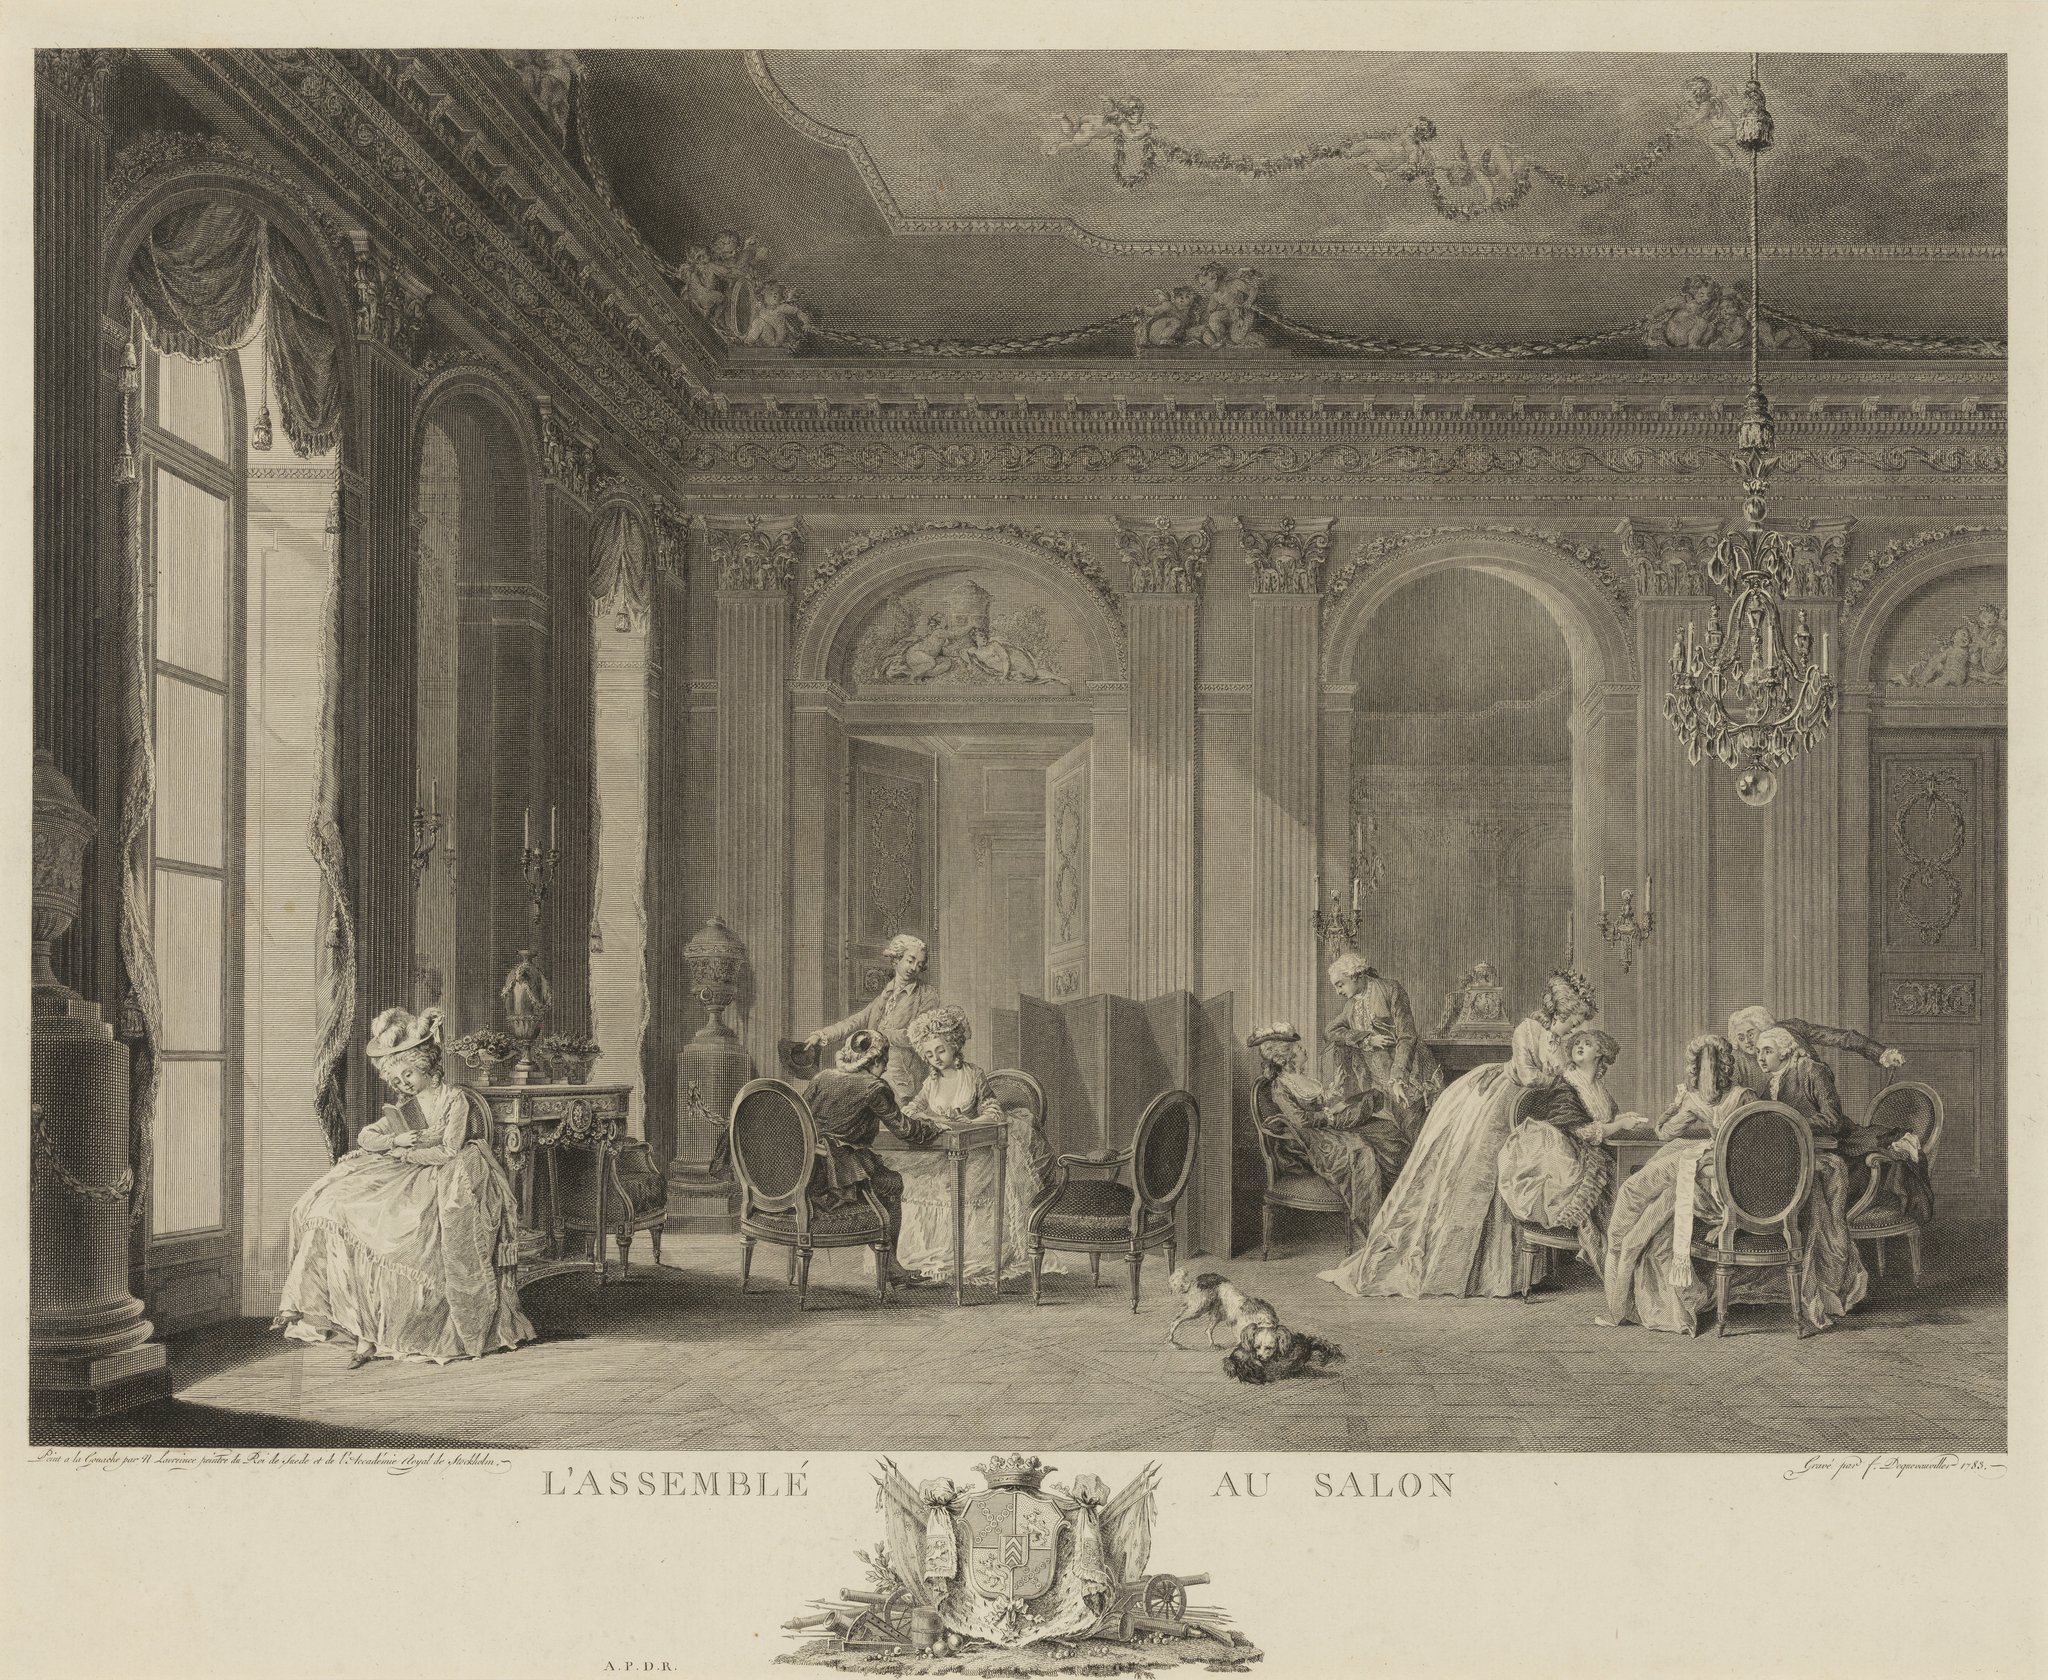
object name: print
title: L'Assemblee au Salon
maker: françois nicolas barthélemy dequevauviller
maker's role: artist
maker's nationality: french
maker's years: 1745-1807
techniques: engraving, etching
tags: interiors,men,women,reading,dogs,coat of arms,screens,chairs,tables,games